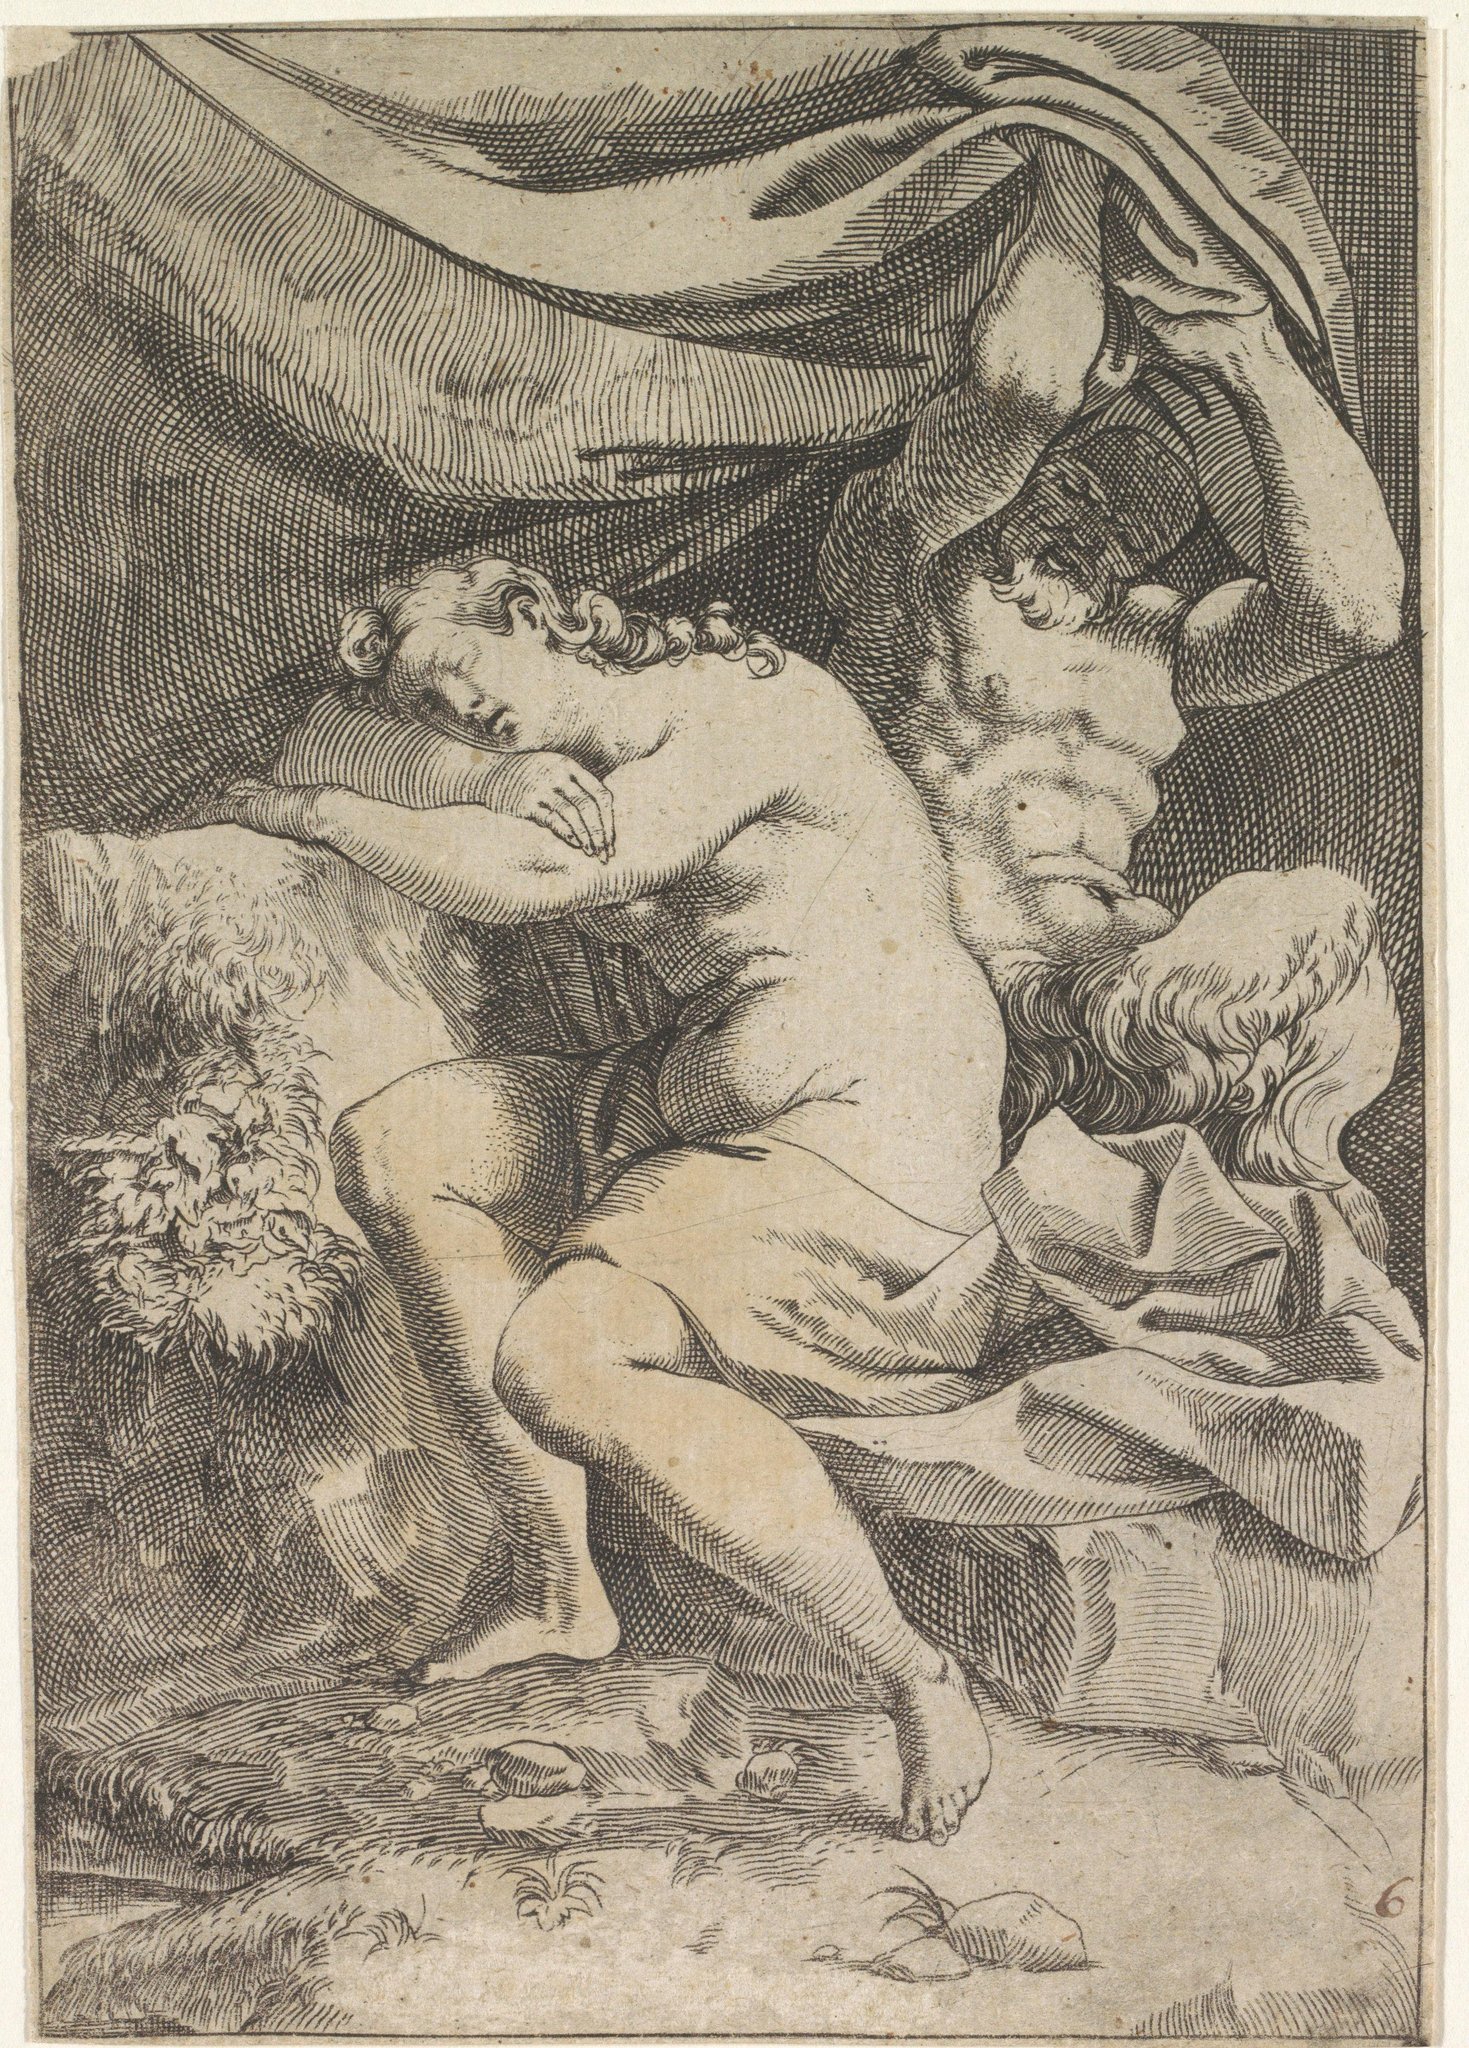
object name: print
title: Sater bespiedt een slapende vrouw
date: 1584-1623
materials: paper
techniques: engraving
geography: italy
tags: satyr(s) spying upon, sleeping; unconsciousness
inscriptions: collector's mark: Lugt 11, number: ‘6’, collector's mark: Lugt 10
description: Een sater gluurt van achter een gordijn naar een naakte slapende vrouw.